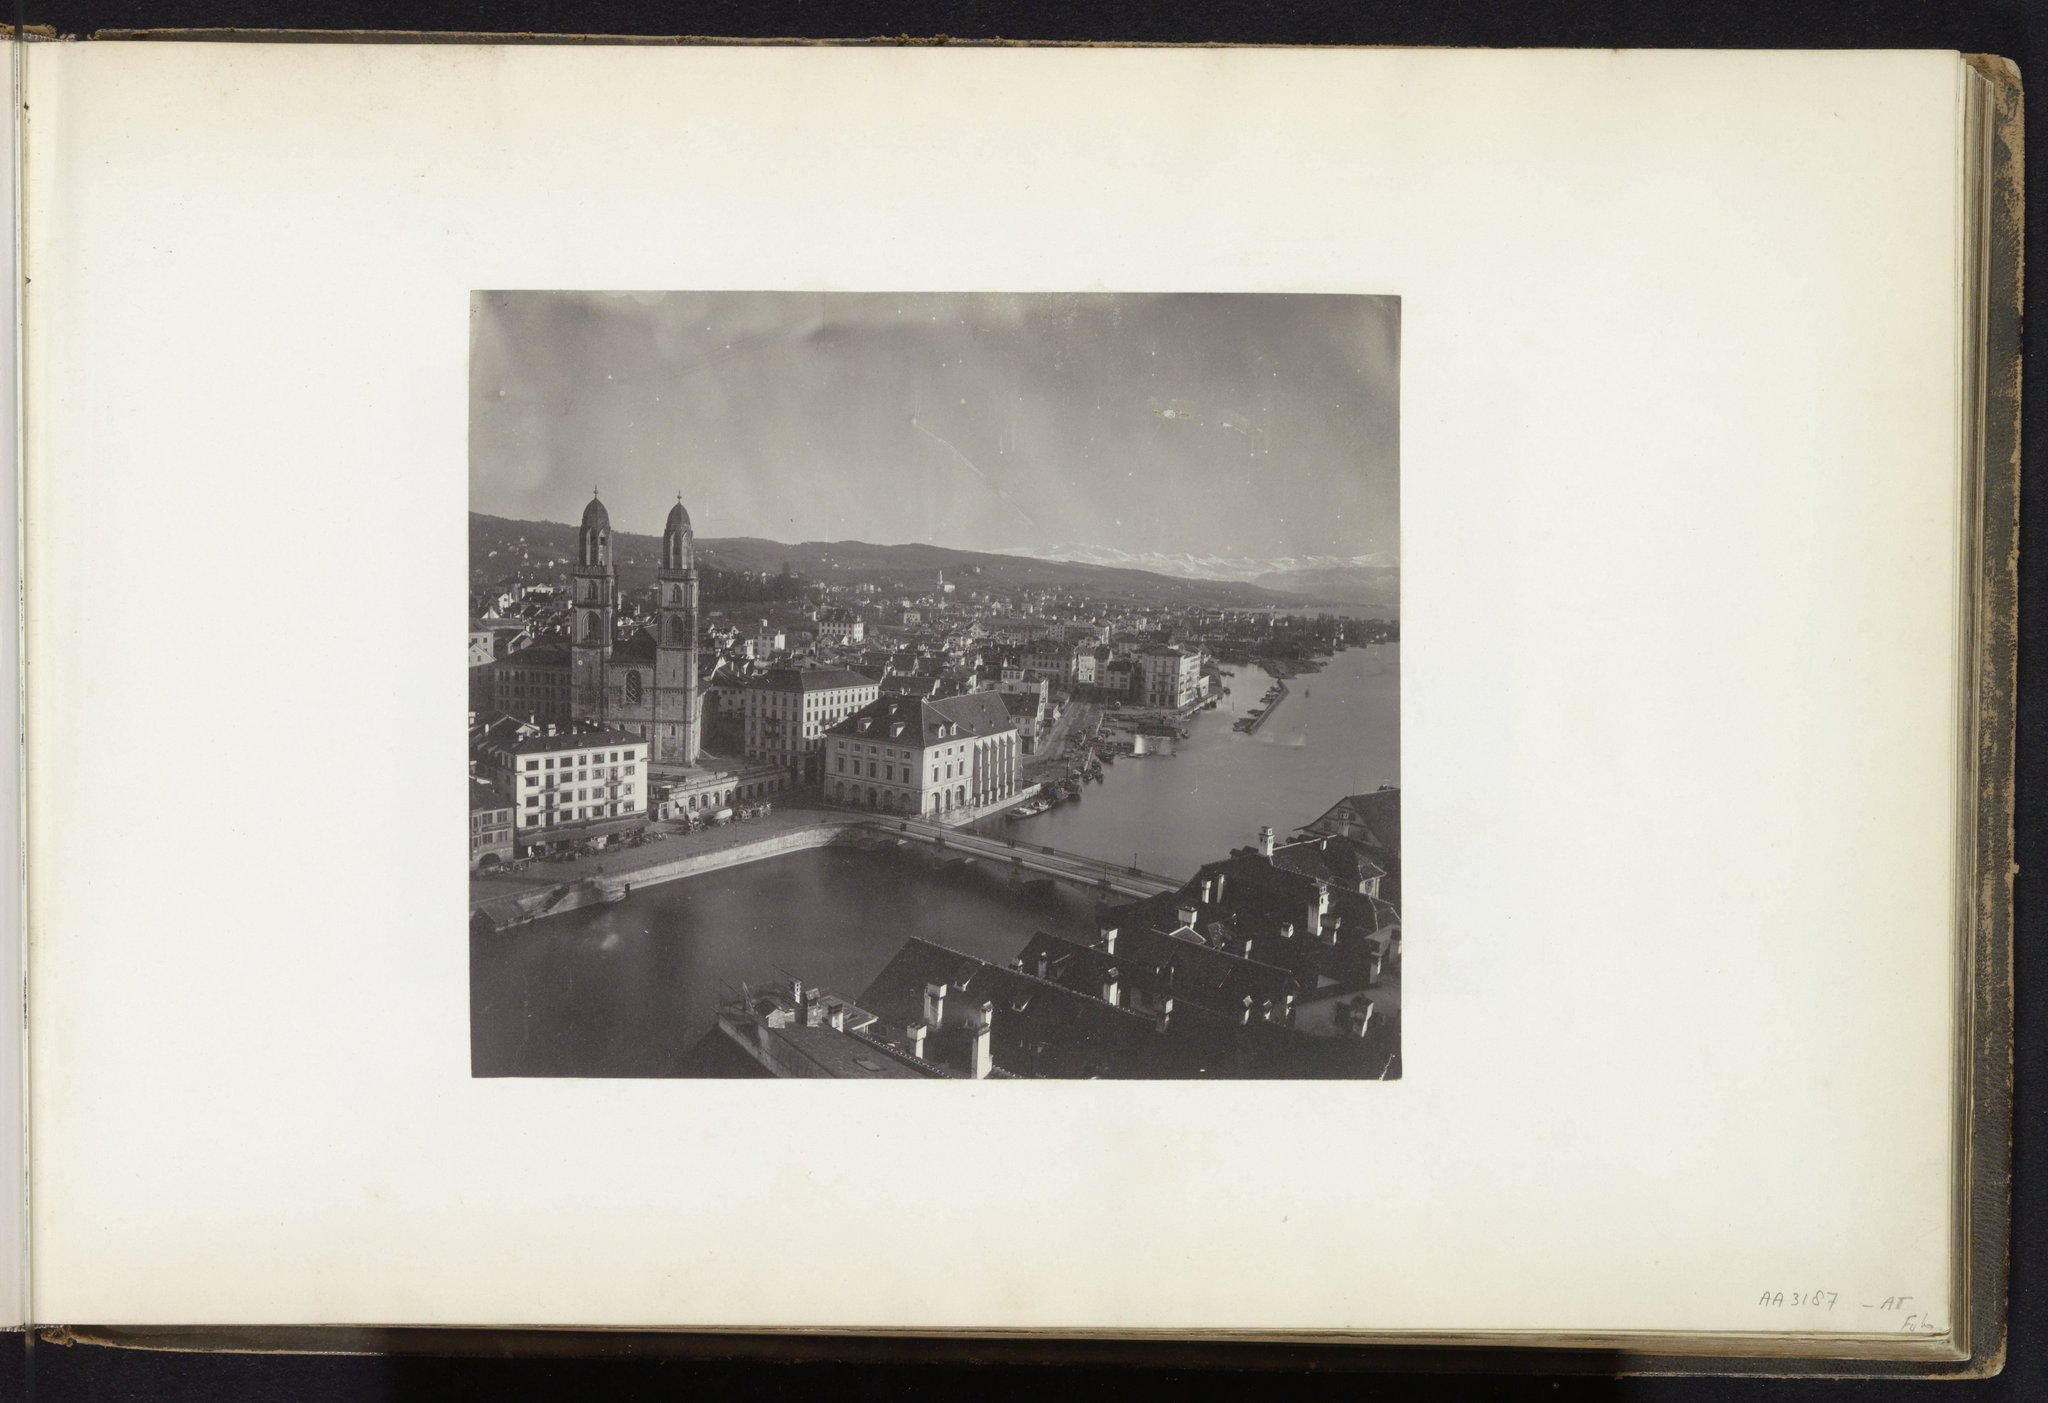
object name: photograph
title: Gezicht op Zürich met links de Grossmünster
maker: Anonymous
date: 1865-1875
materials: photographic support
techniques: albumen print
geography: zurich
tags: church (exterior), bridge in city across river, canal, etc., prospect of city, town panorama, silhouette of city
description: Onderdeel van Reisalbum met opnames van bezienswaardigheden in India, Duitsland, Zwitserland en Frankrijk.